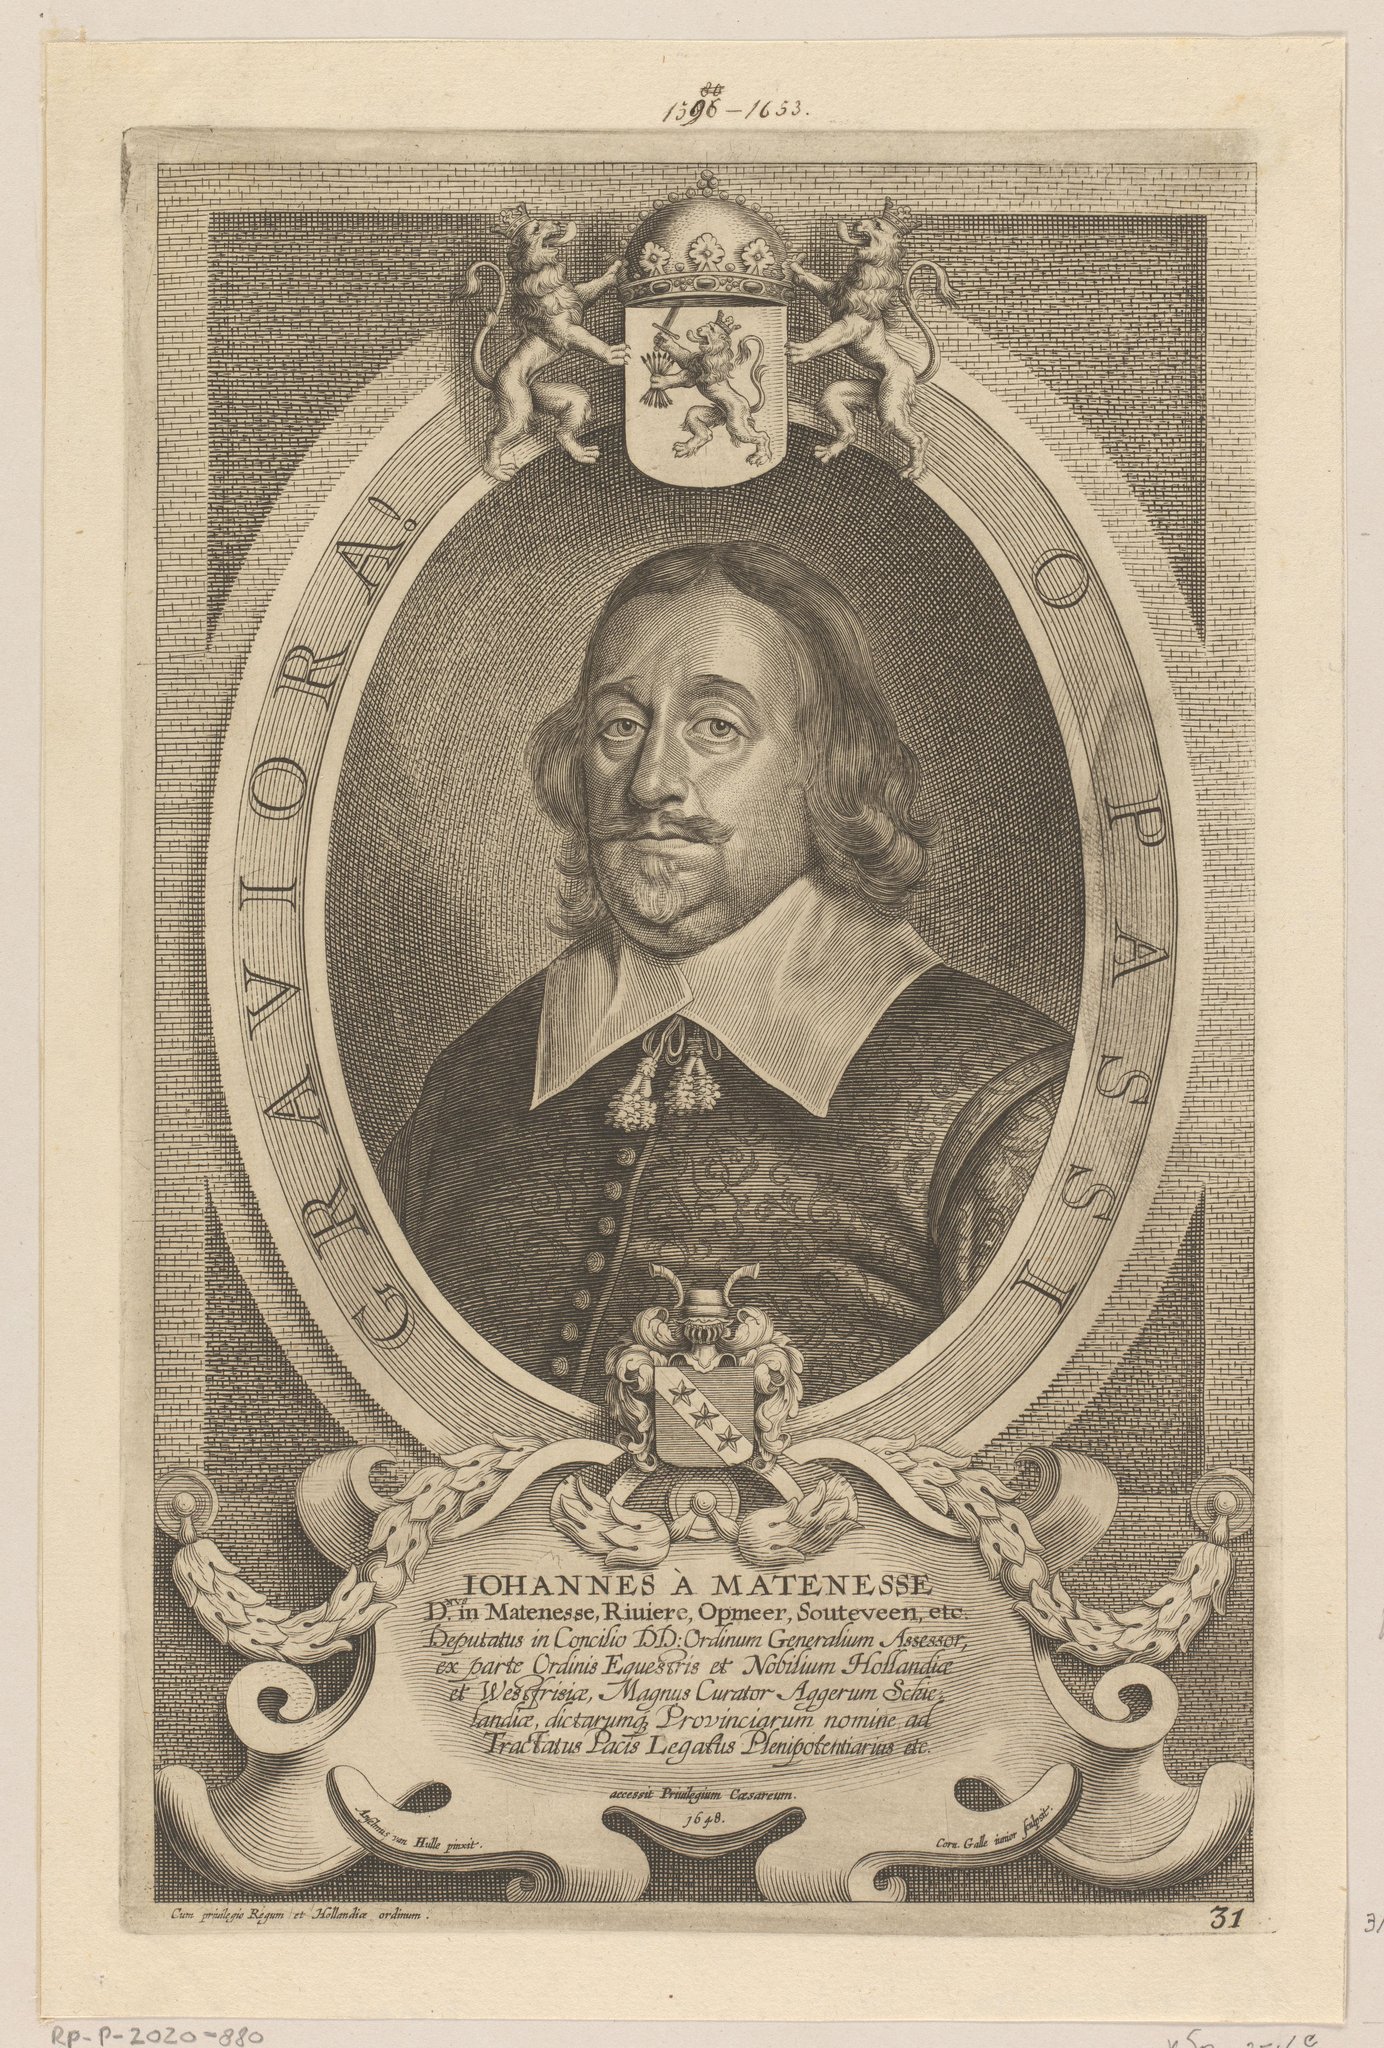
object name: print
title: Portret van Johan van Mathenesse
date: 1697-1717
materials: paper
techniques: engraving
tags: official; civil servant; functionary (in general), historical persons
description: Prent is gebruikt in verschillende series. De huidige staat is gebruikt in de hieronder vermelde serie en uitgaven (6), (7) en (8). (1)'Icones legatorum (...)', uitgegeven door Daniel Middeler in 1648 in Antwerpen. (2)‘Legati Celeberrimi’, uitgegeven door Daniel Middeler in 1648 in Antwerpen. (3)‘Legati Celeberrimi’, waarschijnlijk uitgegeven in 1651, maar opnieuw met de vermelding door Daniel Middeler in 1648 in Antwerpen. (4)‘Legati Celeberrimi', waarschijnlijk uitgegeven in 1658, maar opnieuw met de vermelding door Daniel Middeler in 1648 in Antwerpen. (5) 'Pacificatores orbis Christiani, sive icones principum, ducum et legatorum, qui Monasterii atque Osnabrugae (...)', uitgegeven door Pieter van der Slaart in 1696 in Rotterdam. (6) 'Pacificatores orbis Christiani, sive icones principum, ducum et legatorum, qui Monasterii atque Osnabrugae (...)', uitgegeven door Pieter van der Slaart in 1697 in Rotterdam. (7) 'Pacificatores orbis Christiani, sive icones principum, ducum et legatorum, qui Monasterii atque Osnabrugae (...)', waarschijnlijk uitgegeven circa 1713, maar opnieuw met vermelding van Pieter van der Slaart in 1697 in Rotterdam. De platen in deze uitgave zijn voor het eerst genummerd. (8) 'Les hommes illustres qui ont vécu dans le XXIIe siècle (...)', uitgegeven door David Mortier in 1717 in Rotterdam. Zie documentatie. Mogelijk zijn er nog meerdere uitgaven en staten van deze prent.